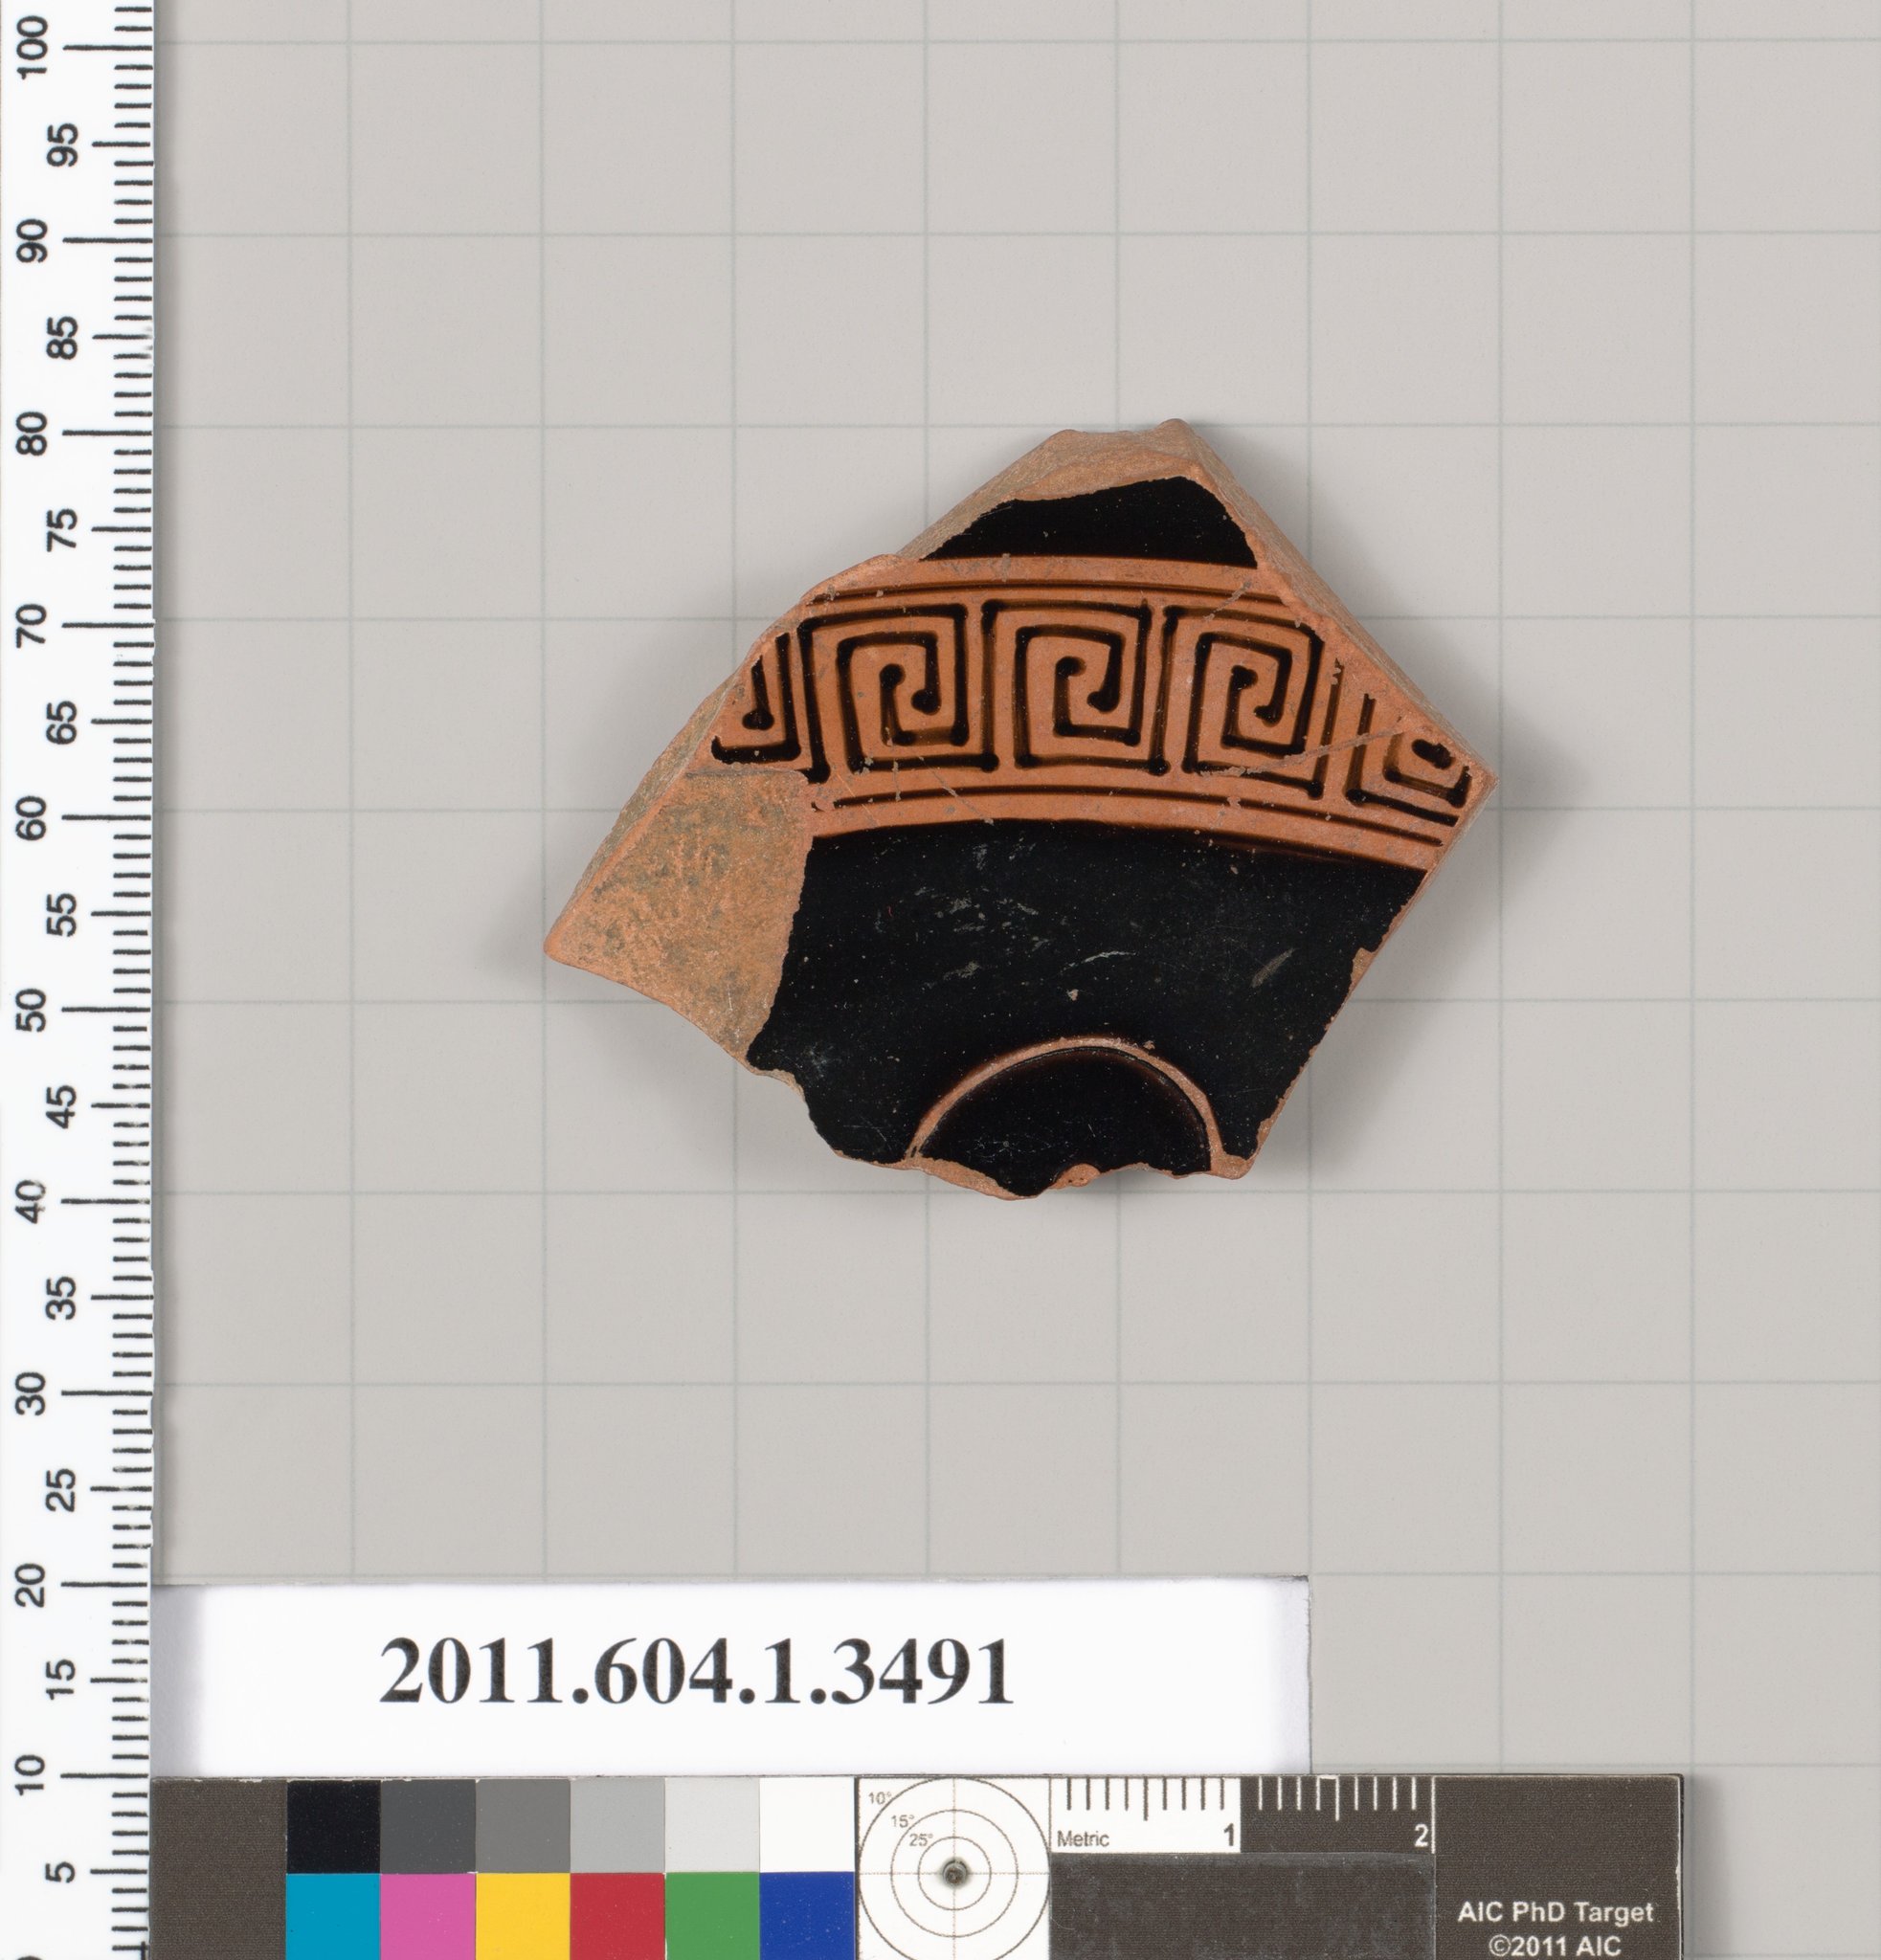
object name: kylix fragment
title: Terracotta fragment of a kylix (drinking cup)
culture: greek, attic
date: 490-470 BCE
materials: terracotta